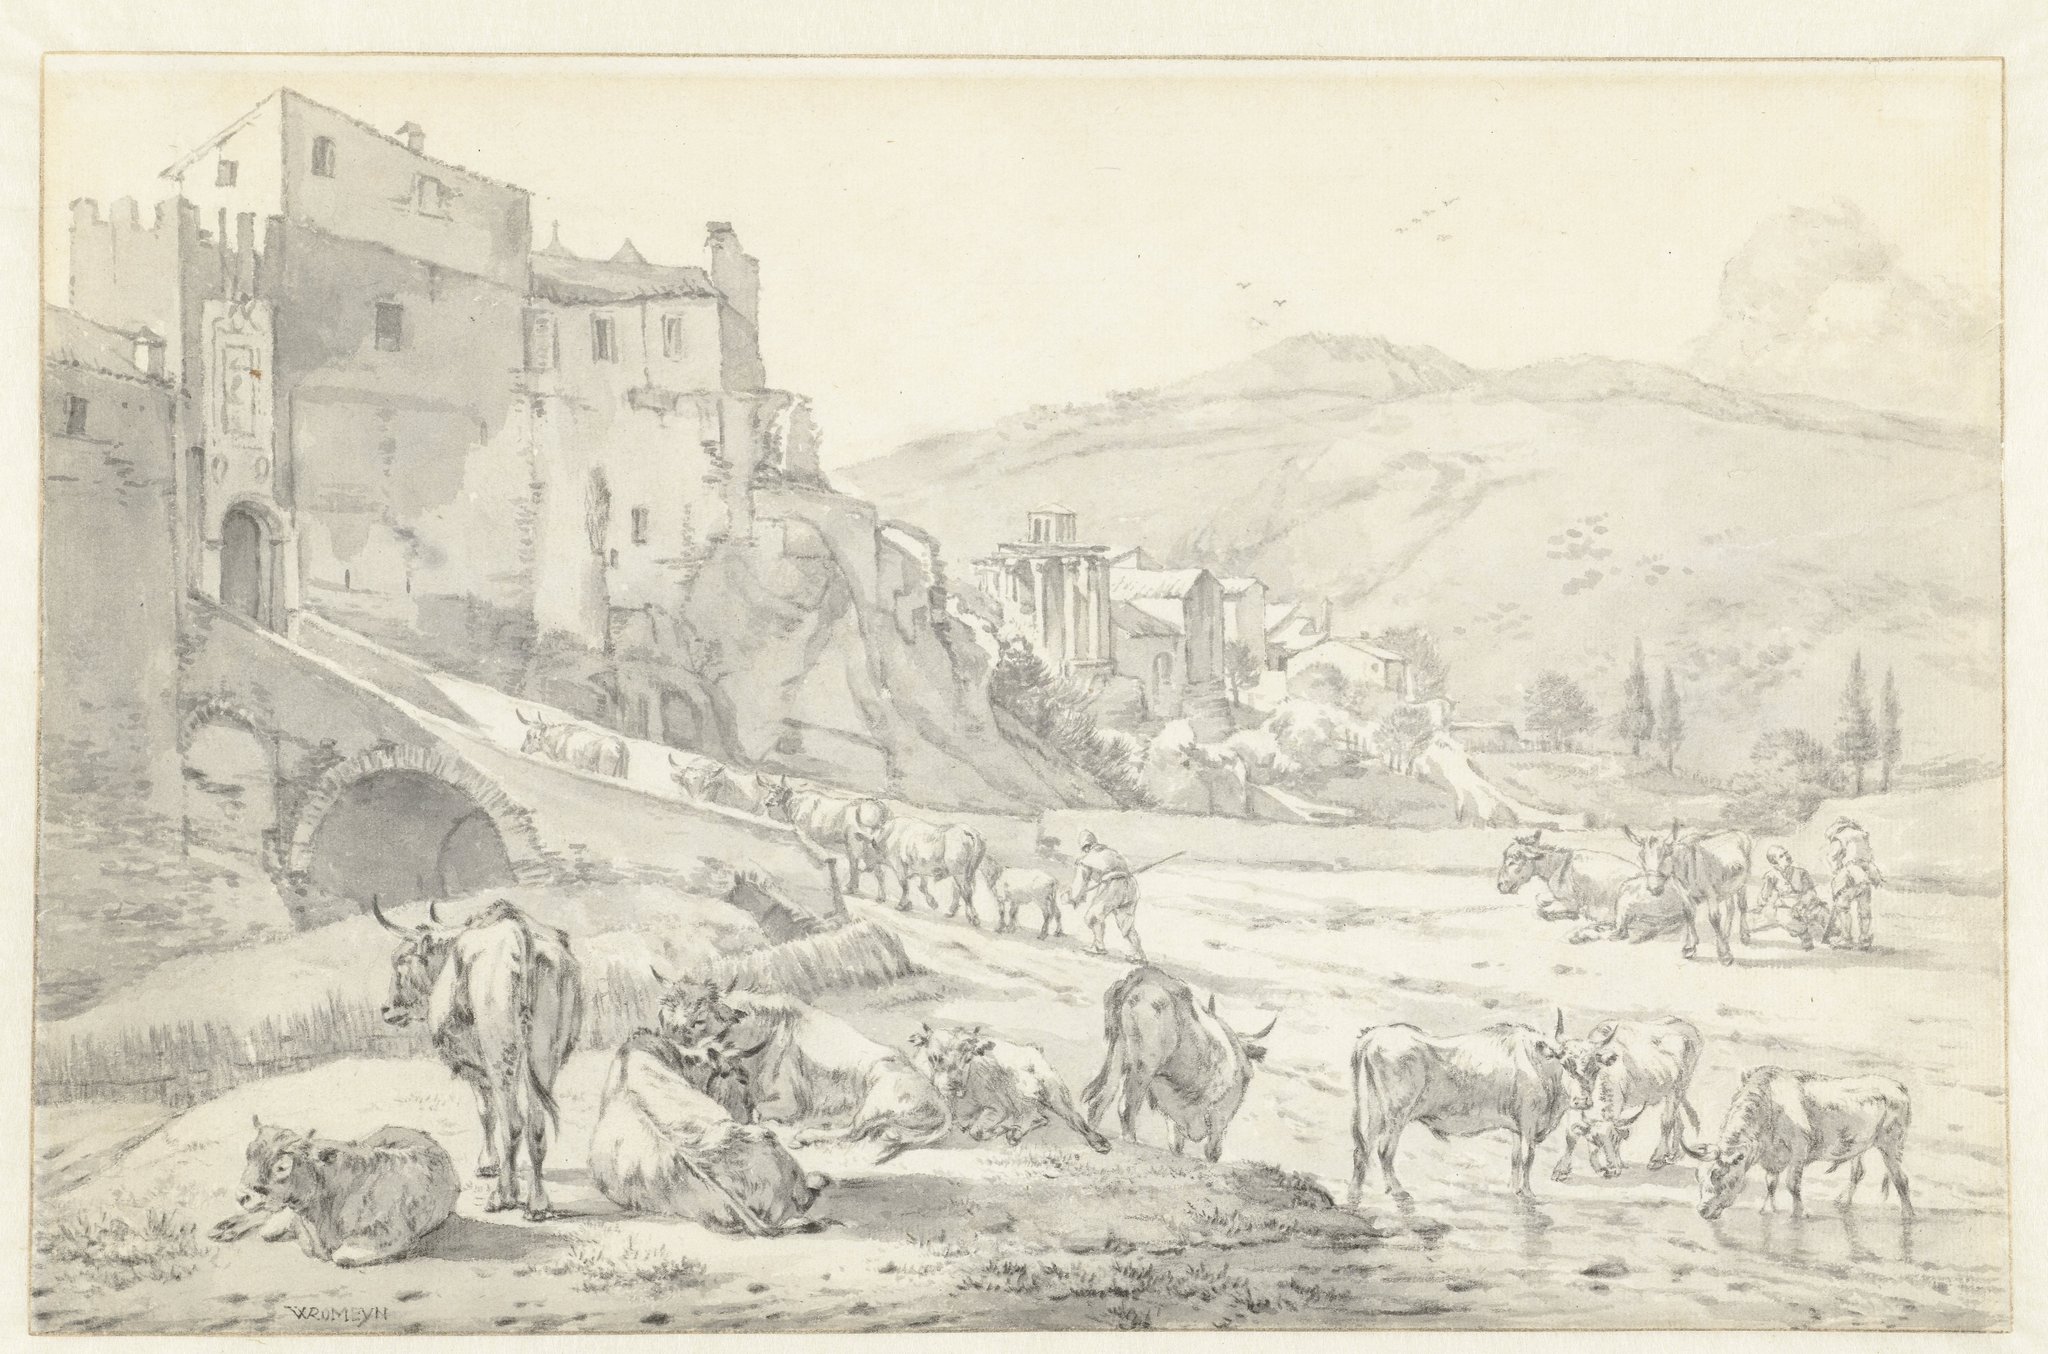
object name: drawing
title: Cattle in front of the Porta Sant’Angelo in Tivoli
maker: willem romeyn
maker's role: draughtsman, painter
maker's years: 1624-1694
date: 1660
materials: chalk, graphite, ink, paper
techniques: brush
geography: haarlem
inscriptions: signature: ‘WR(ineen)omeyn’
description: Italianiserend landschap bij Tivoli, Porta Sant'Angelo, met koeien en de tempel van de Sibylle op de achtergrond.